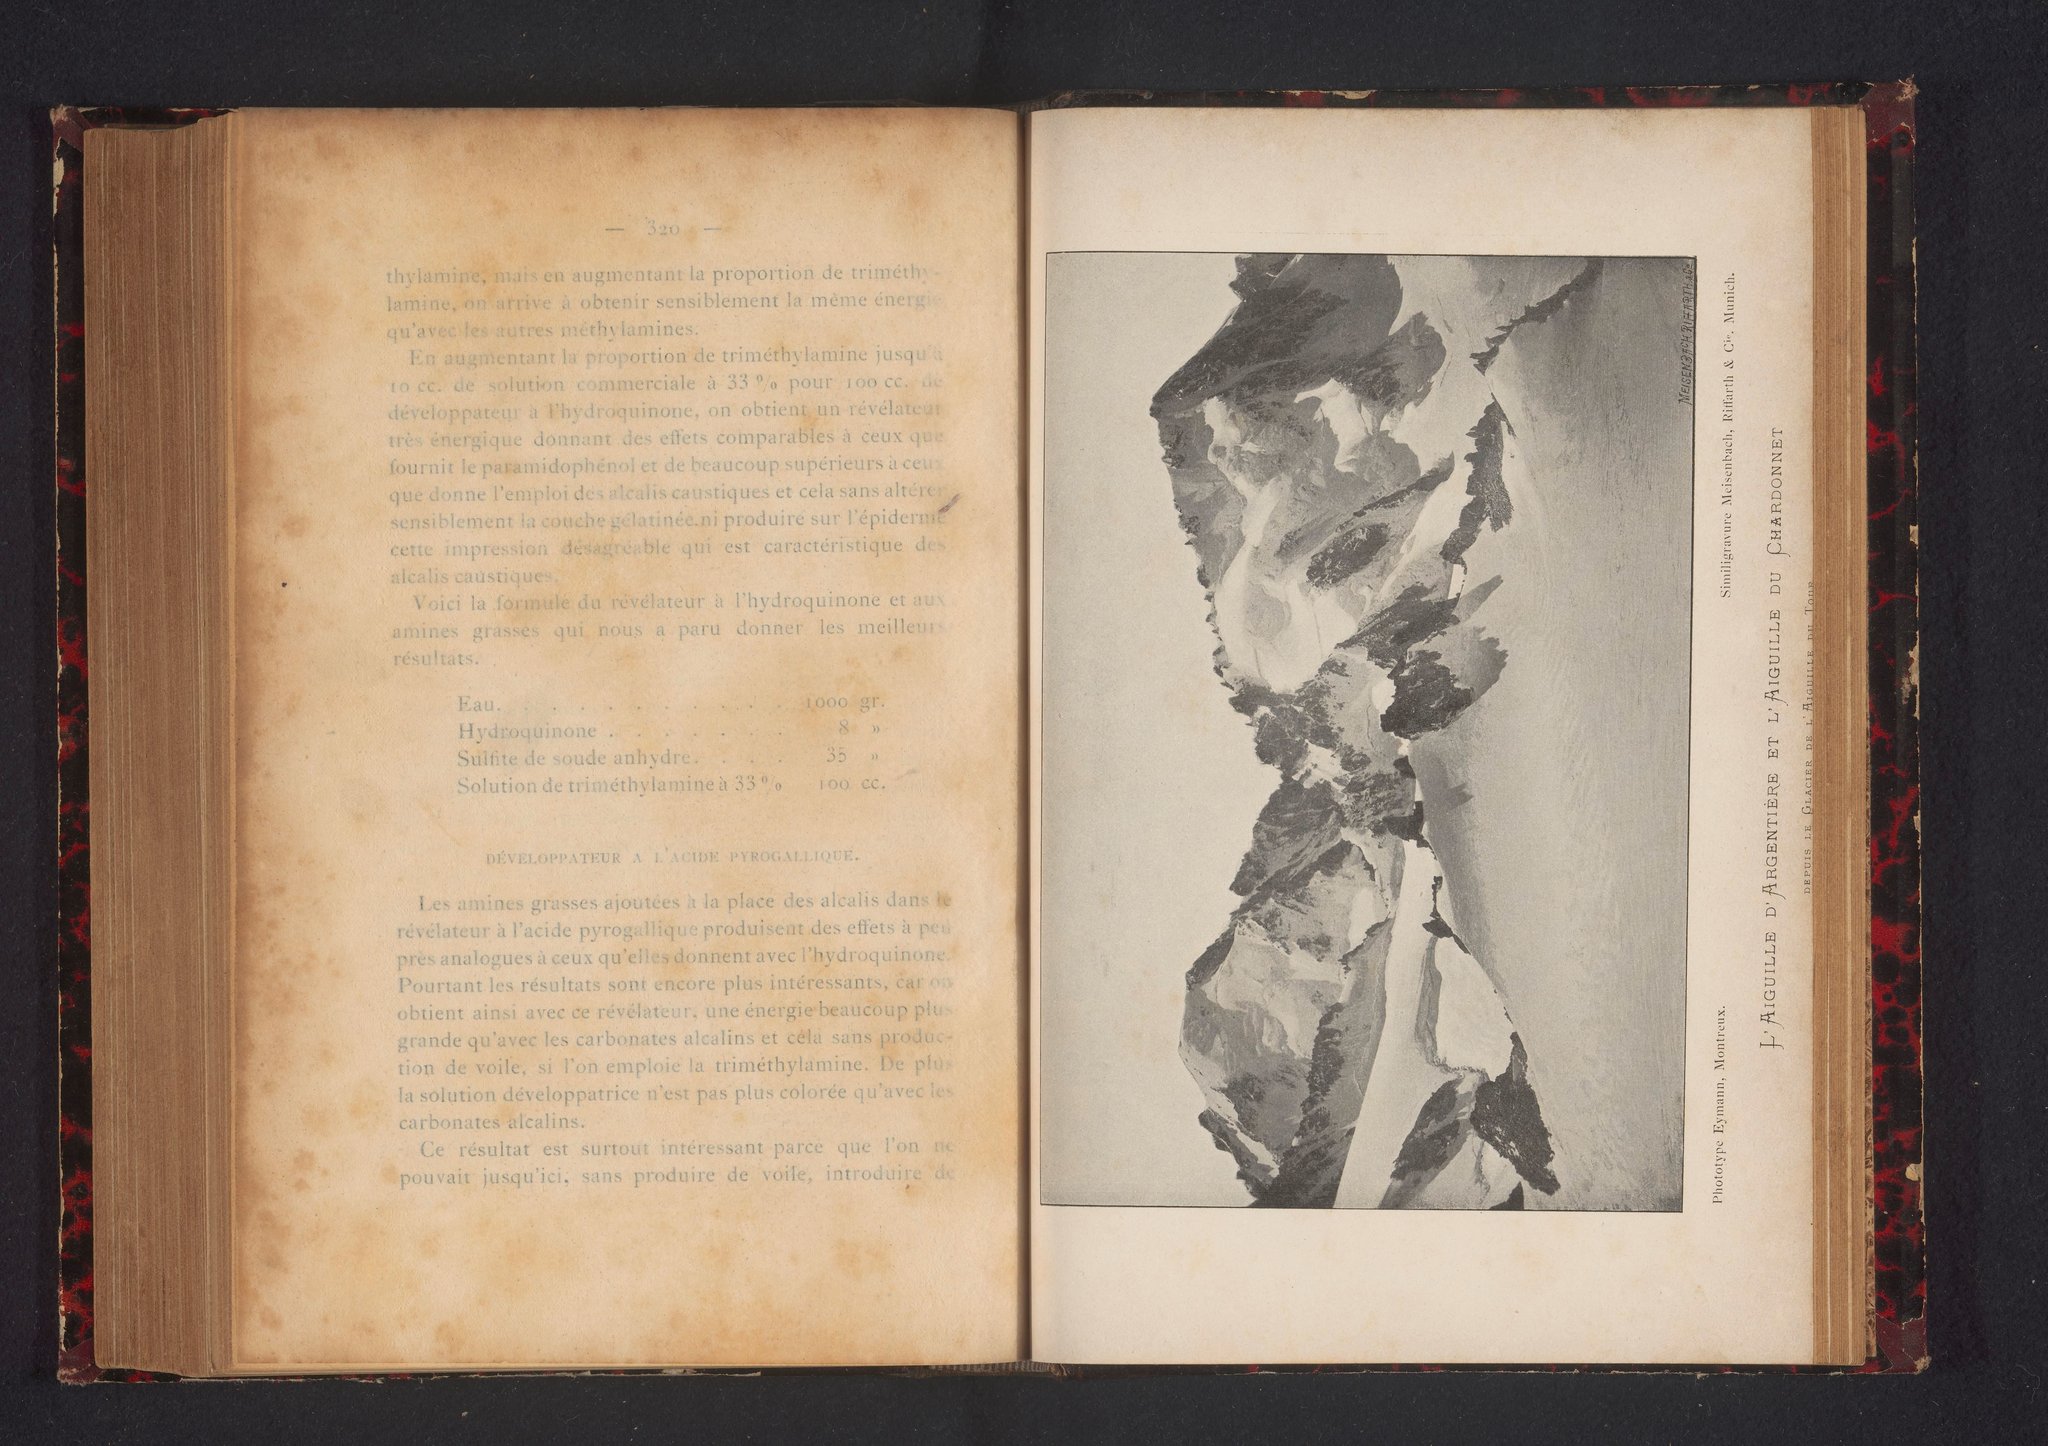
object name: page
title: Gezicht op de Aiguille d'Argentières en de Aiguille de Chardonnet in de Franse Alpen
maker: eymann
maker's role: fotograaf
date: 1893-1898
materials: paper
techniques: autotype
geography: munich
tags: mountain-range, snow peaks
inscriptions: inscription: ‘depuis le Glacier de l'Aguille du Tour’